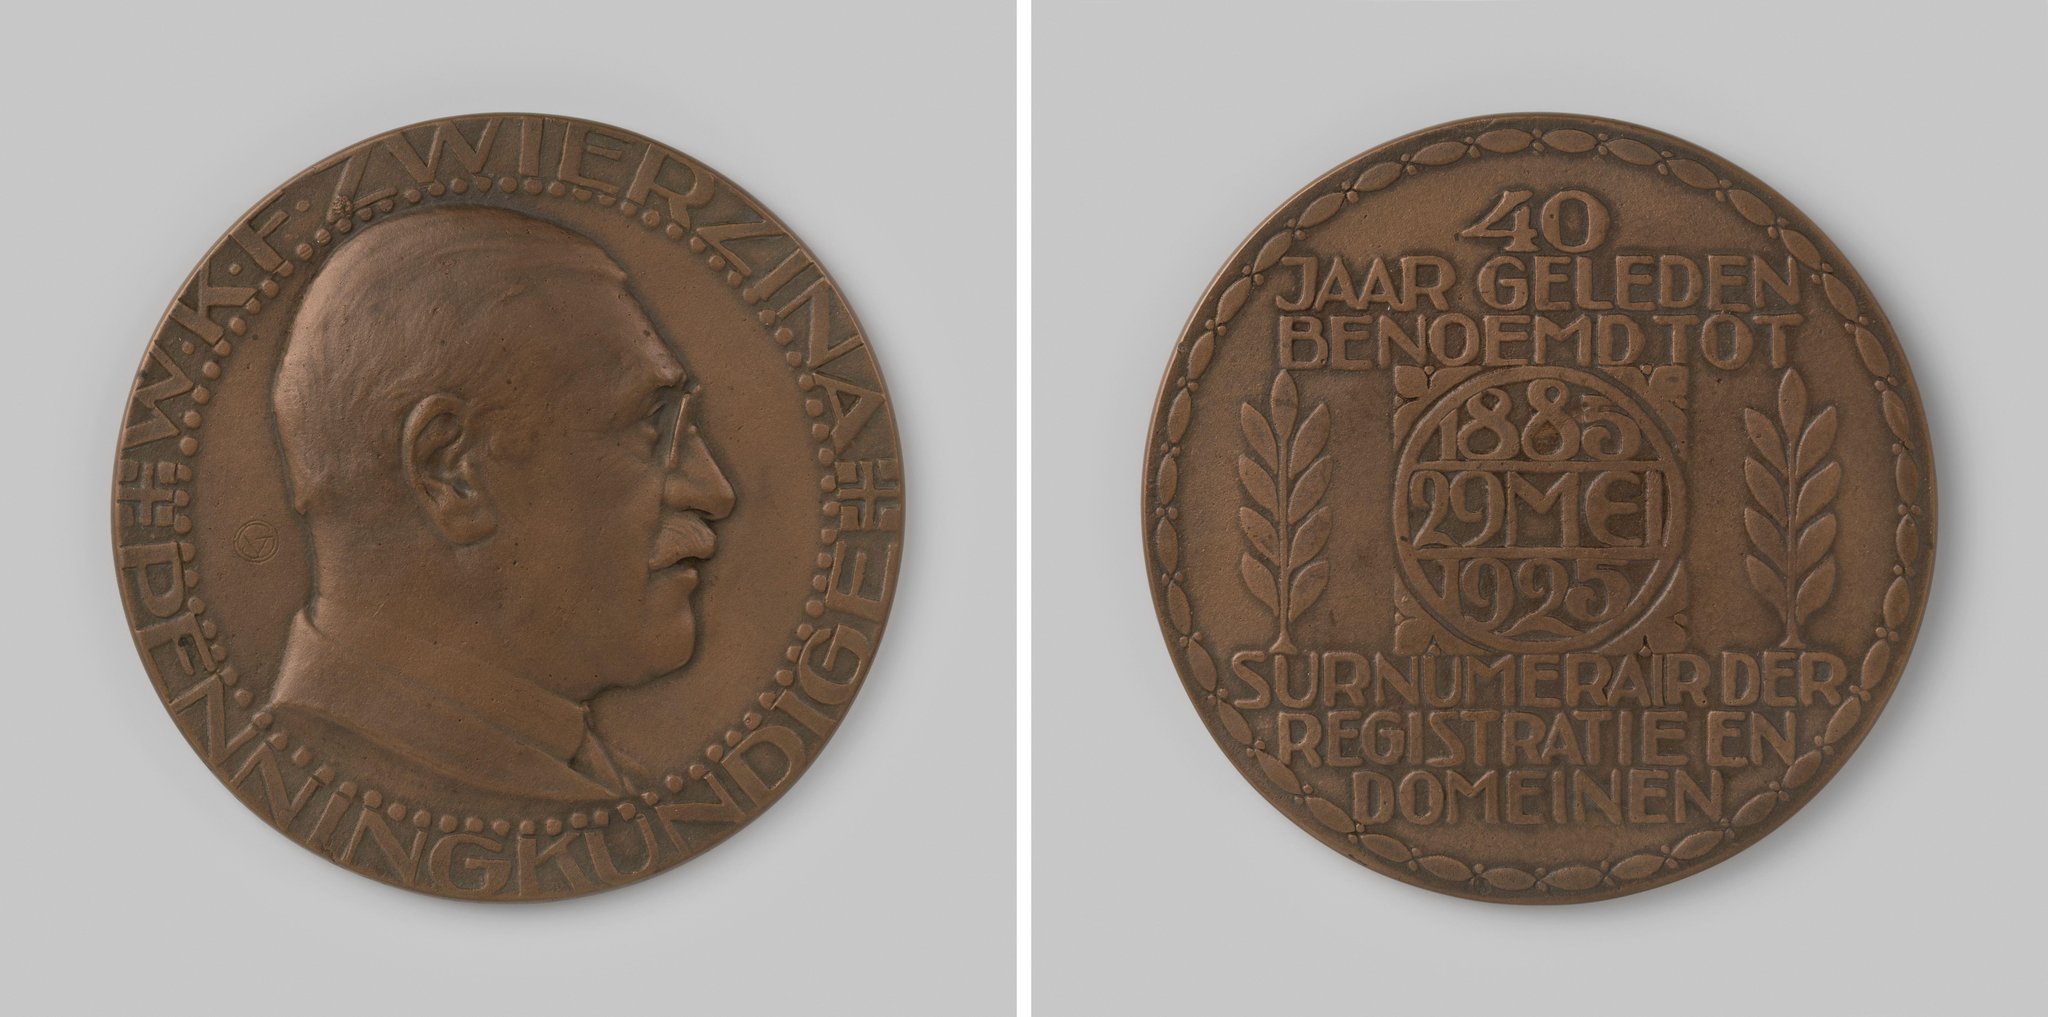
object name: history medal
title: Veertigjarige herdenking van de aanstelling van W.K.F. Zwierzina, penningkundige, bij Registratie en Domeinen 1925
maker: jacob jan van goor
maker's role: medailleur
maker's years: 1874-1956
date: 1925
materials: bronze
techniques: striking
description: Grote gegoten bronzen penning, op de voorzijde het borstbeeld van Zwierzina naar rechts met omschrift, op de keerzijde een versierde cirkel met drie regels tekst, tussen twee opstaande lauwertakken, met boven en onder drie regels tekst.